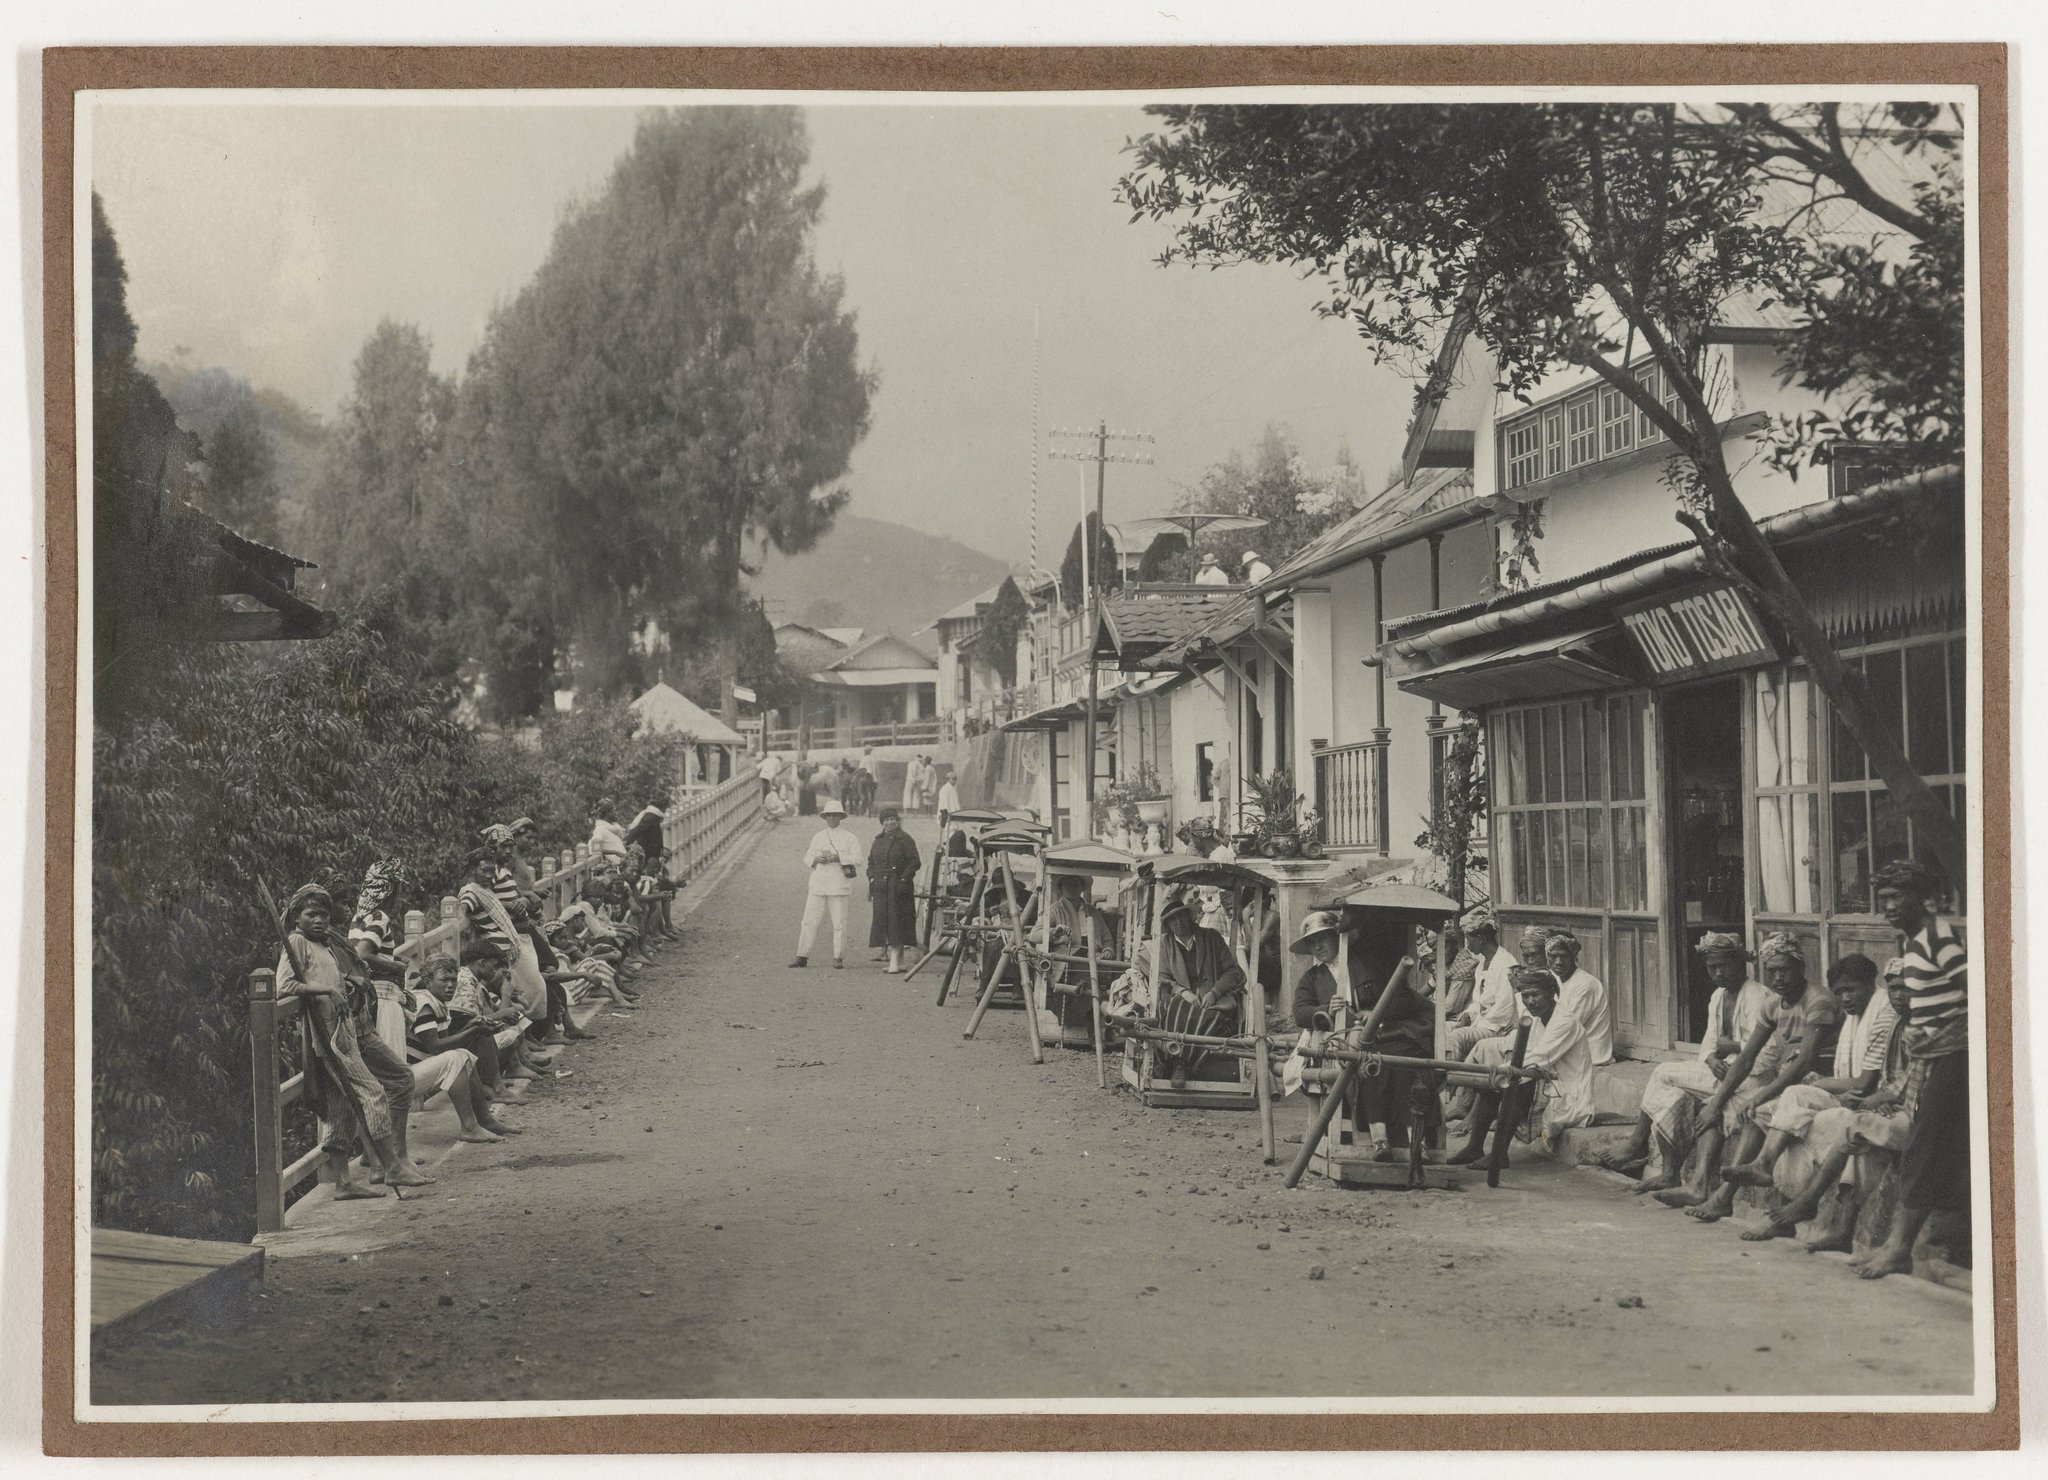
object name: photograph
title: Gezicht in een stadje met reizigers in draagstoelen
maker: Anonymous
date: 1900-1915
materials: cardboard, paper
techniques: gelatin silver print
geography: indonesia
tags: village street, indonesia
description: De foto is uitgesneden uit een album. Op de achterkant van deze foto met smalle witte rand is het verknipte gedeelte van een grotere foto met huizen te zien: RP-F-00-6125-B.